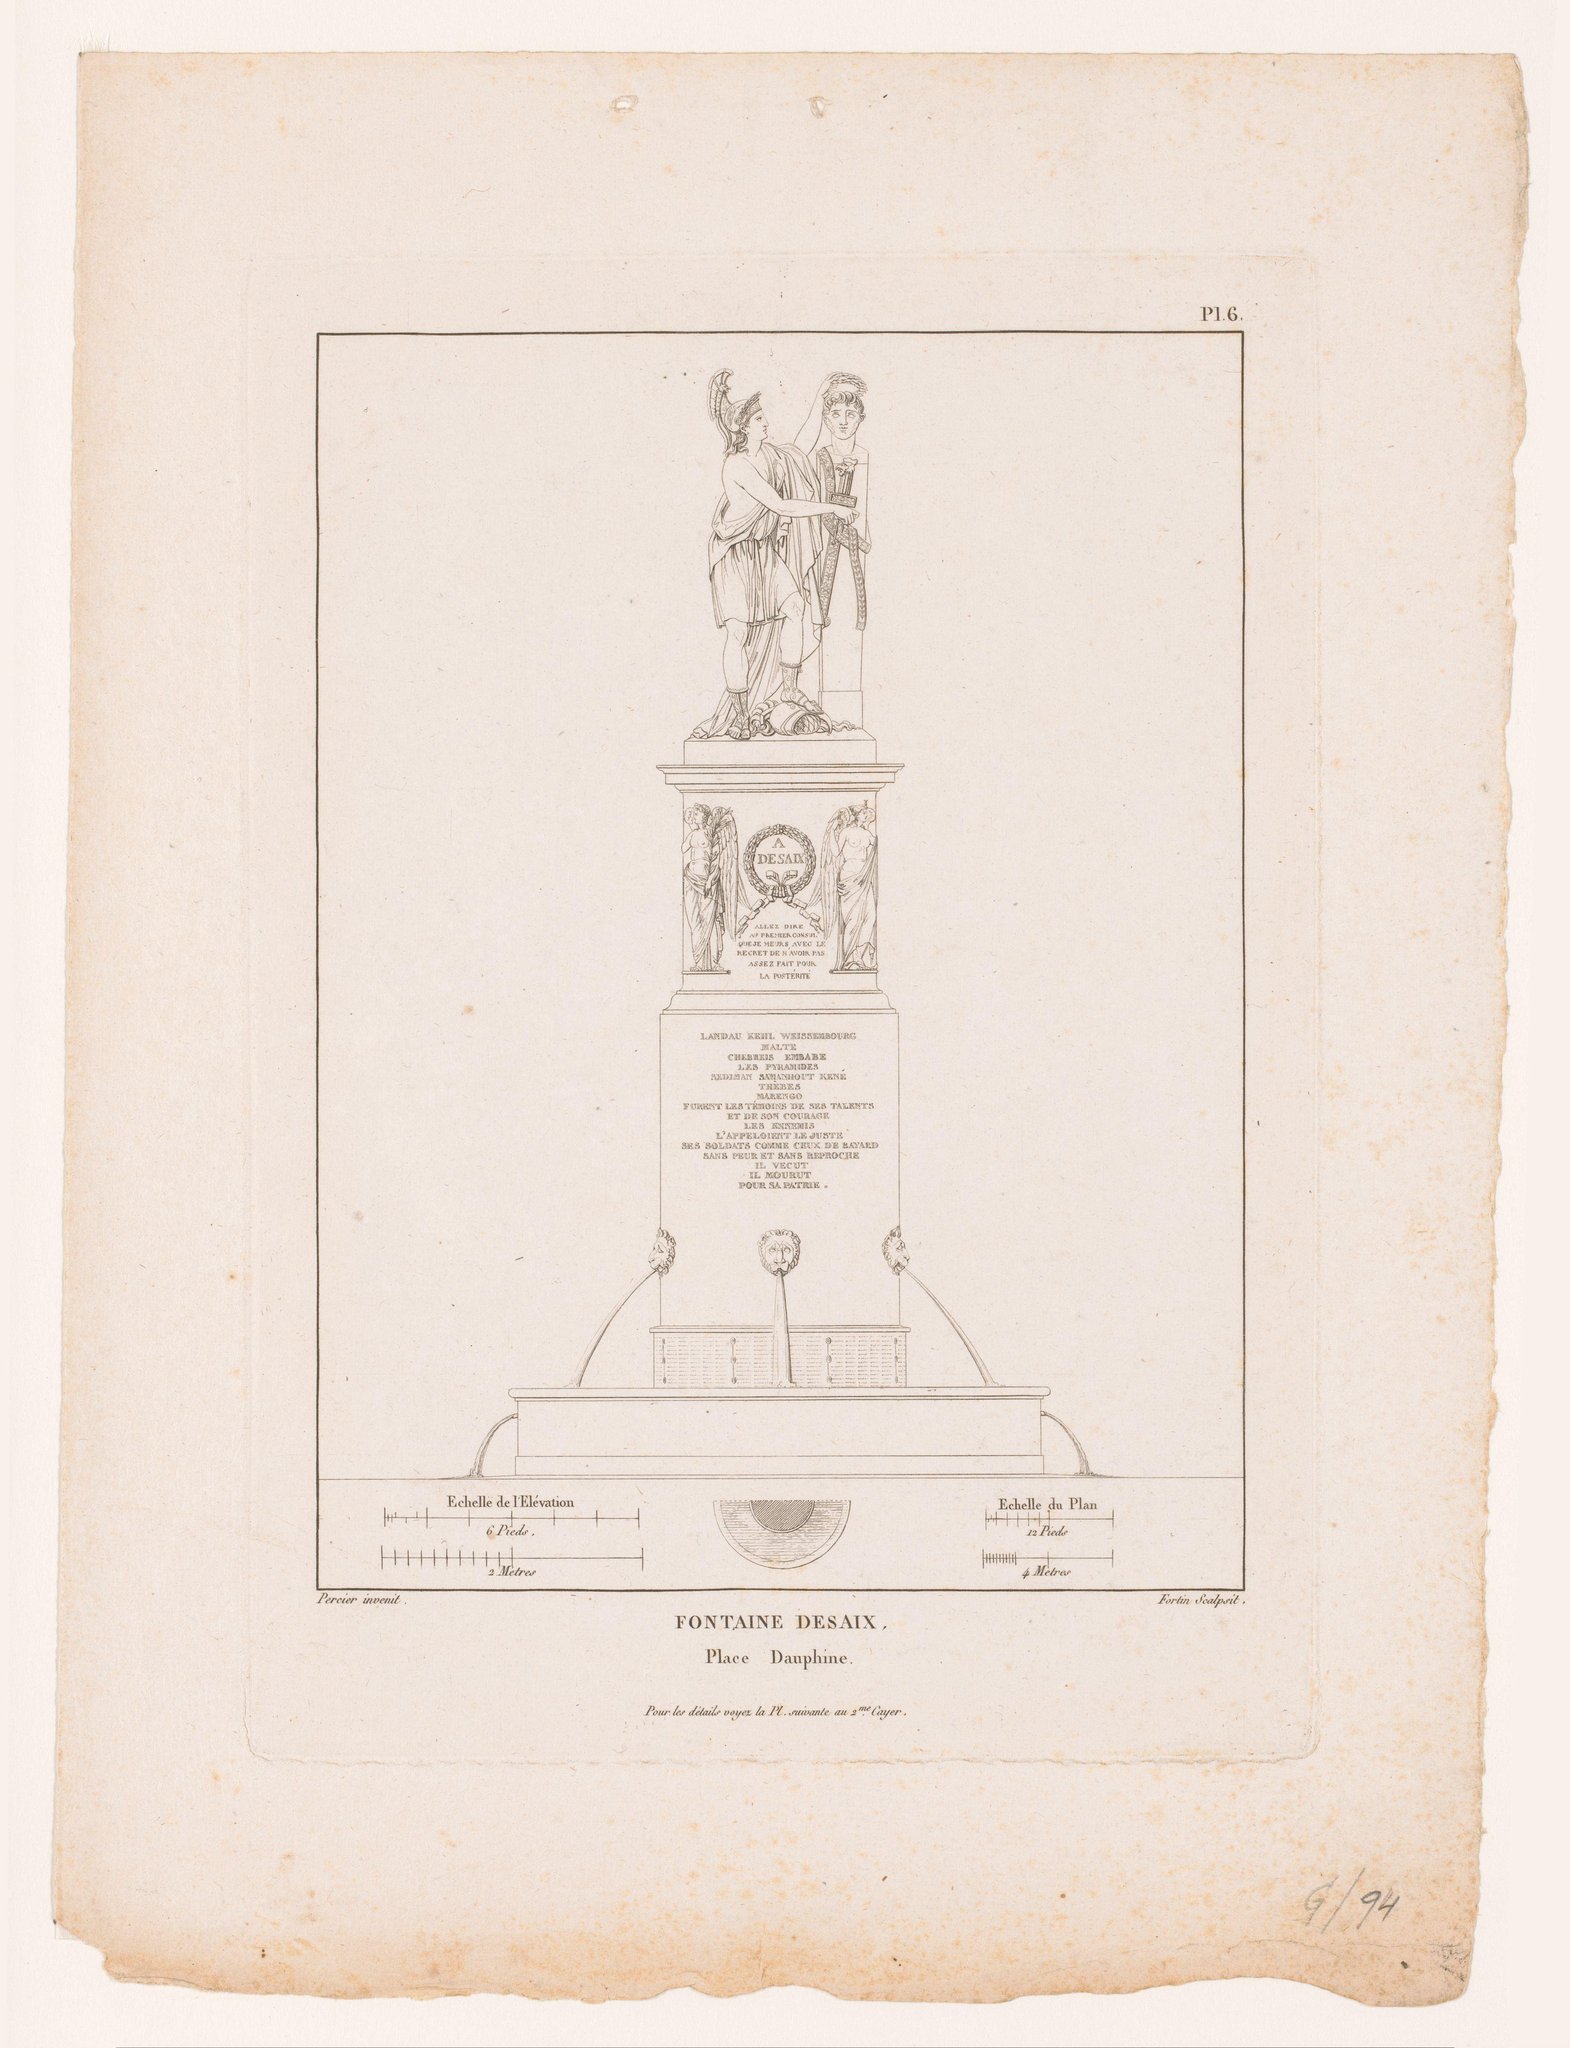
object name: book illustration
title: Fontein Desaix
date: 1828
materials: paper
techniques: engraving, etching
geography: paris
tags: ornamental fountain (in village)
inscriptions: collector's mark: Lugt 2228, collector's mark: Lugt 2760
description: Prent uit: Amaury Duval, Eugène. Les Fontaines de Paris, anciennes et nouvelles. Parijs: Charles Bance, 1828.